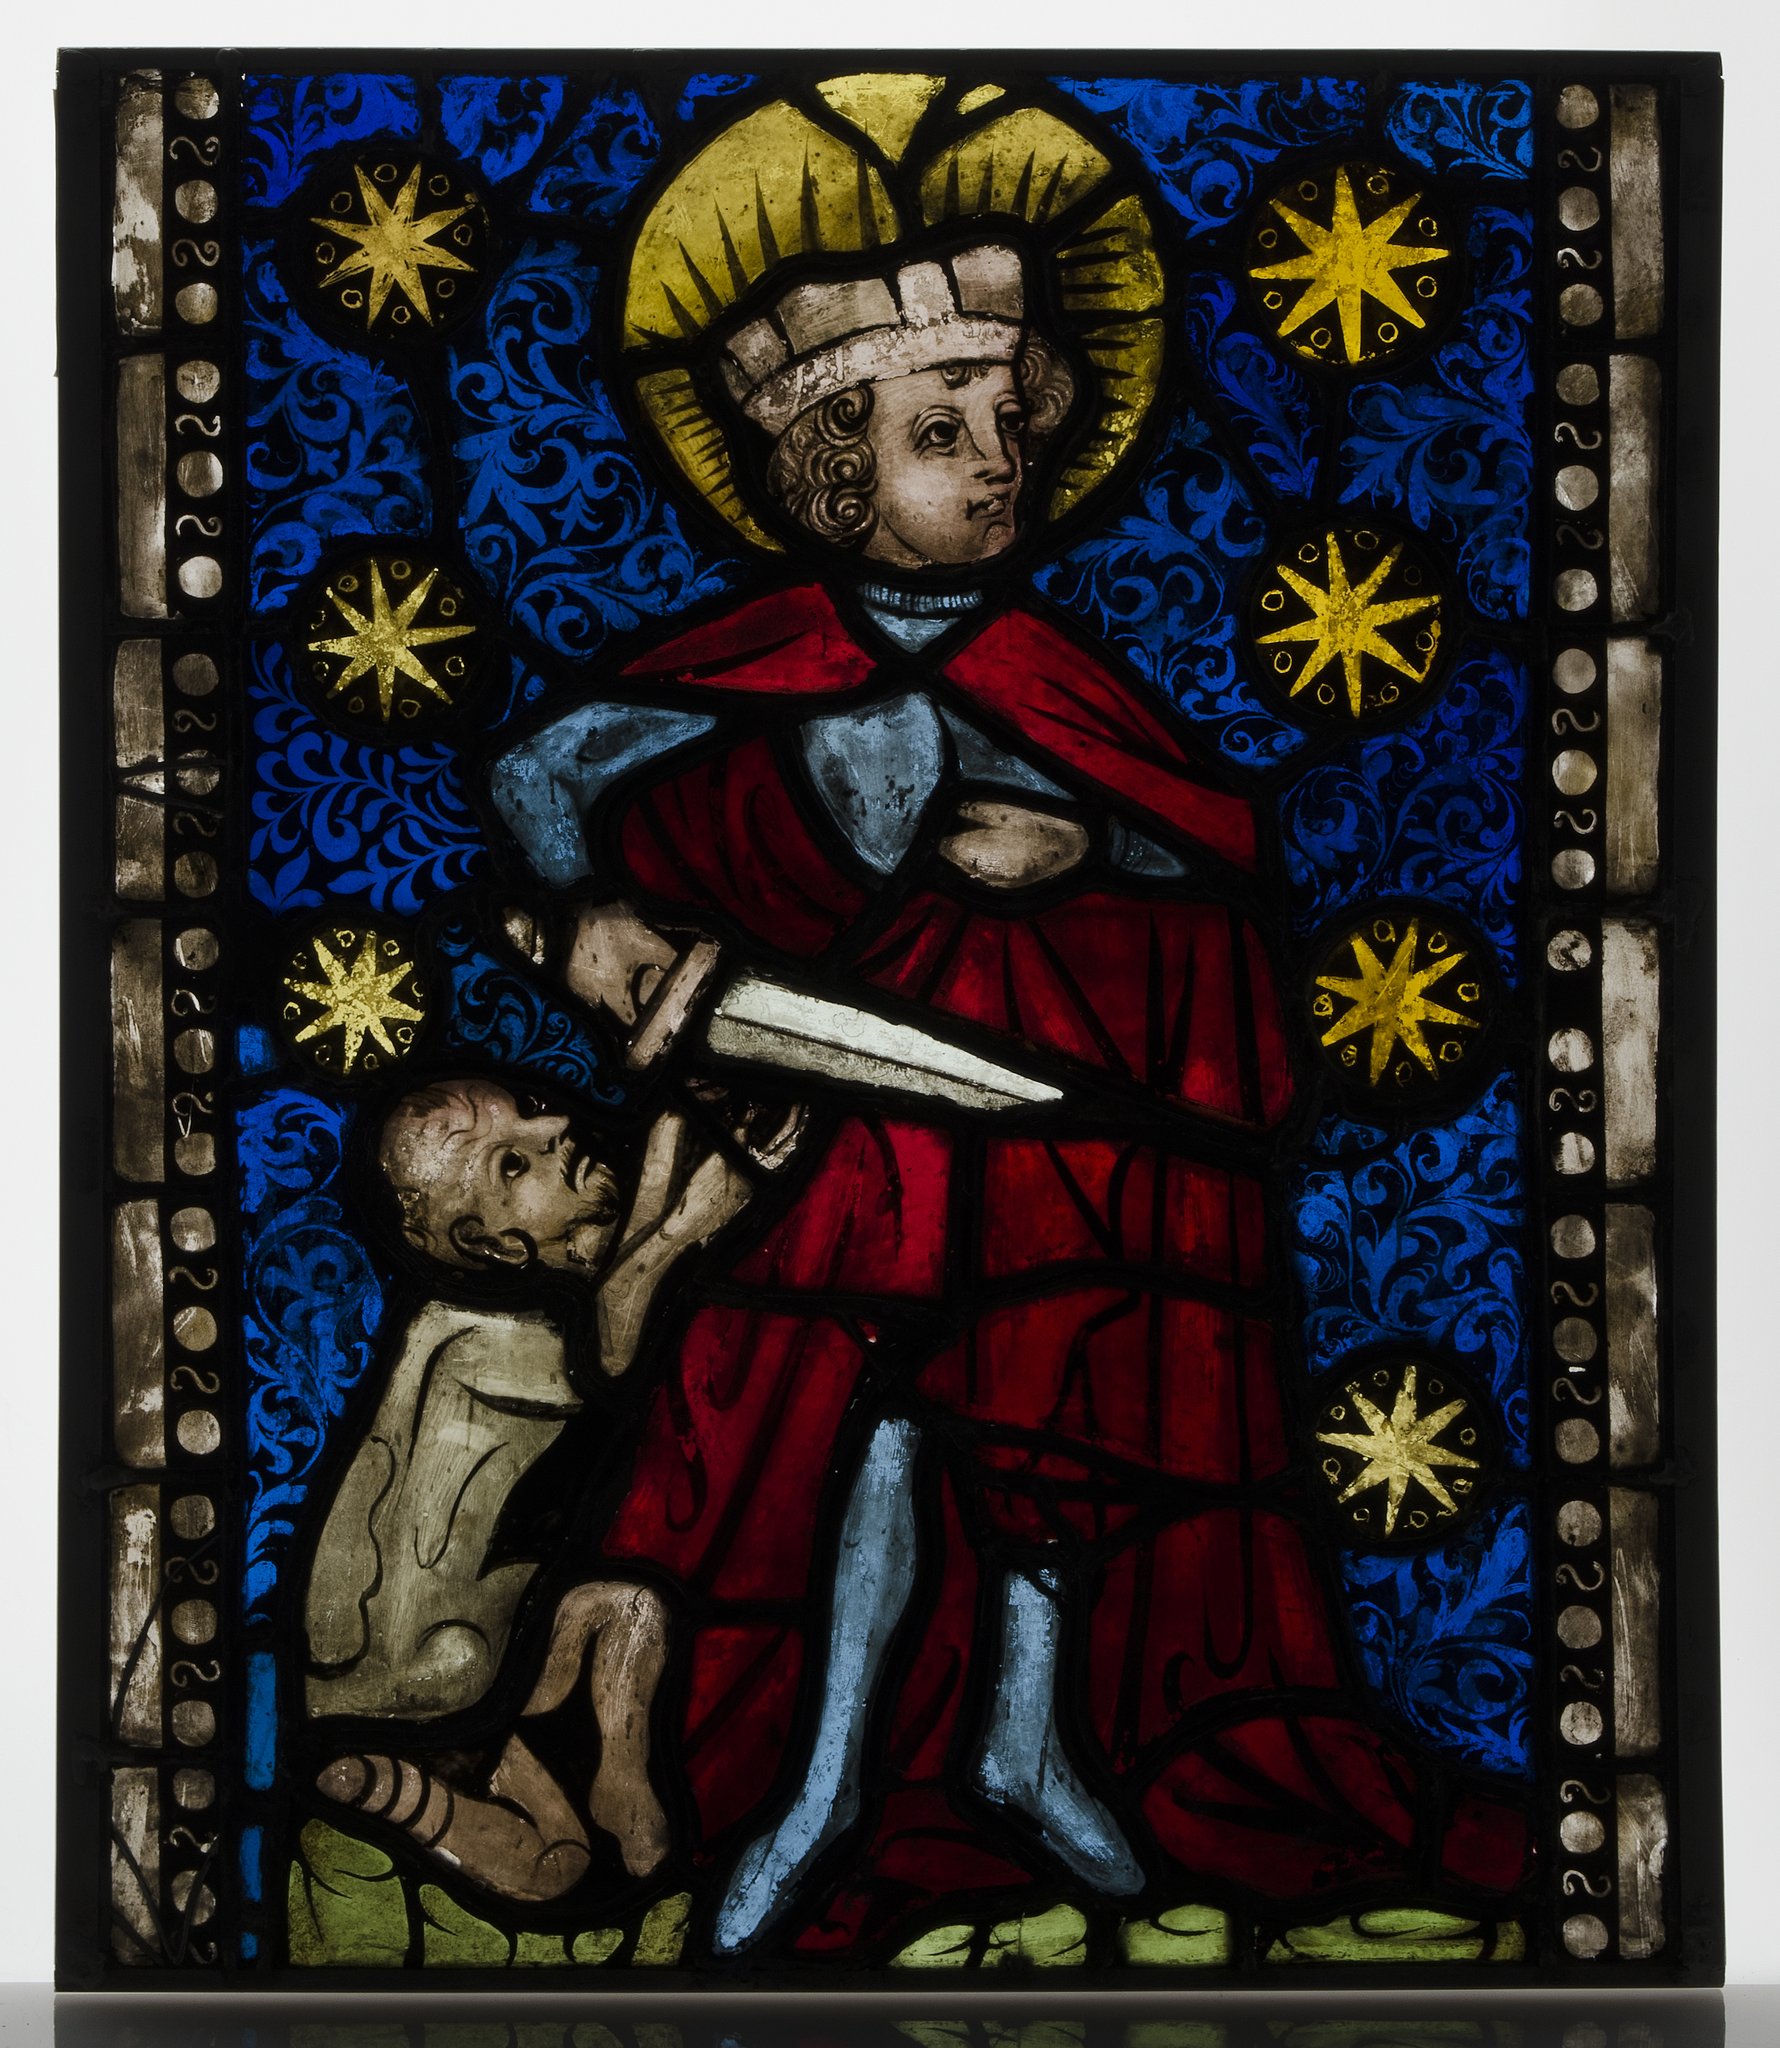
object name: panel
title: Saint Martin Dividing His Cloak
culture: austrian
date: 1410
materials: glass, metal, paint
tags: swords,men,saints